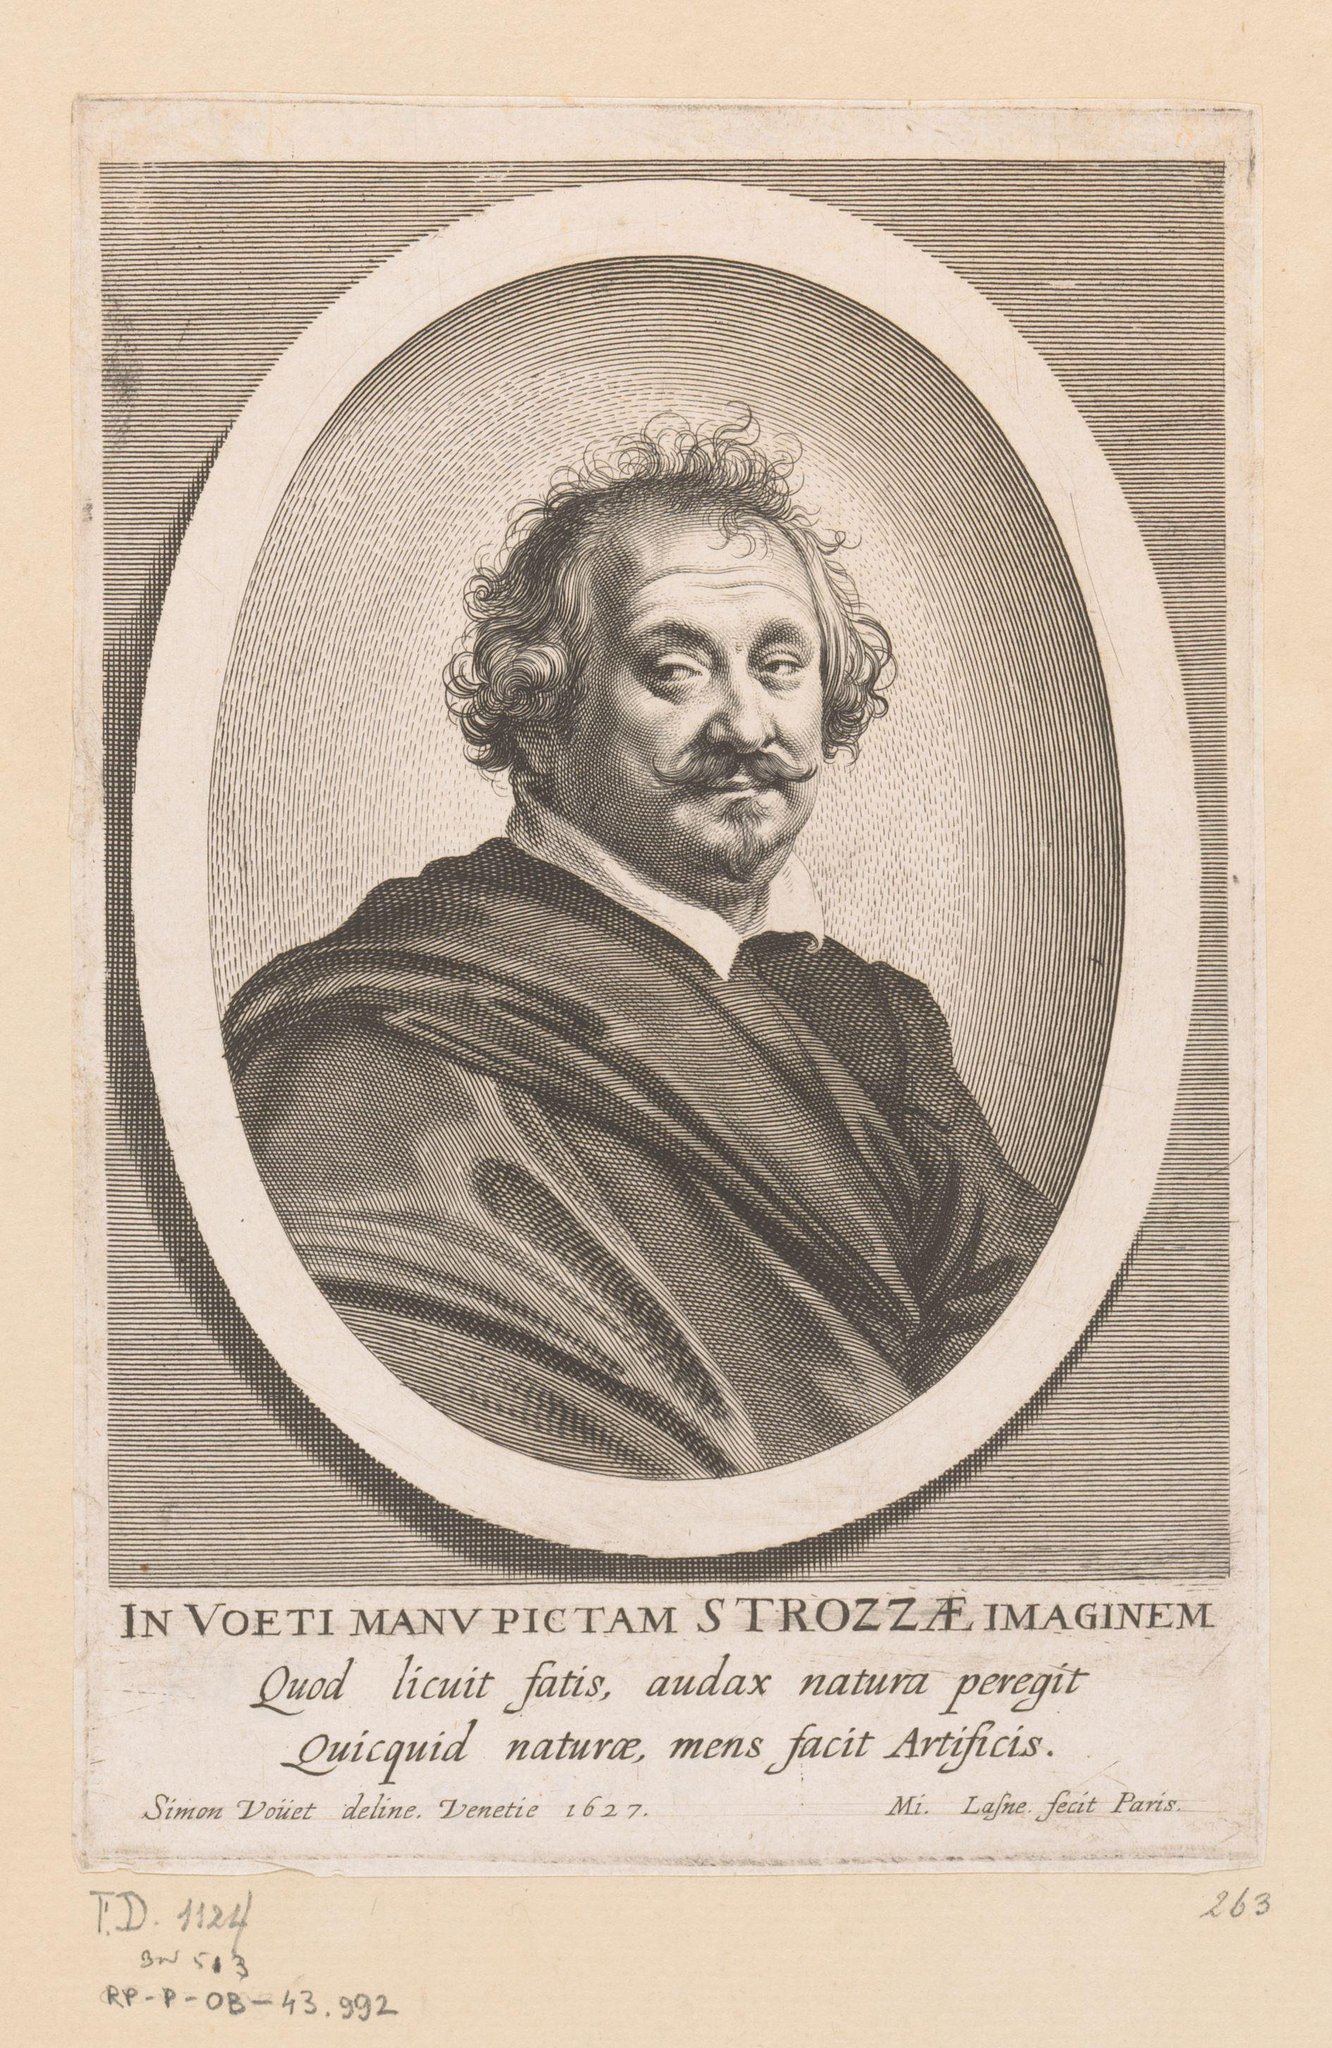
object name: print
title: Portret van Bernardo Strozzi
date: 1627-1667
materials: paper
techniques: engraving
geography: venice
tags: venice, draughtsman, bernardo strozzi, historical persons, portrait, self-portrait of artist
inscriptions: collector's mark: Lugt 240